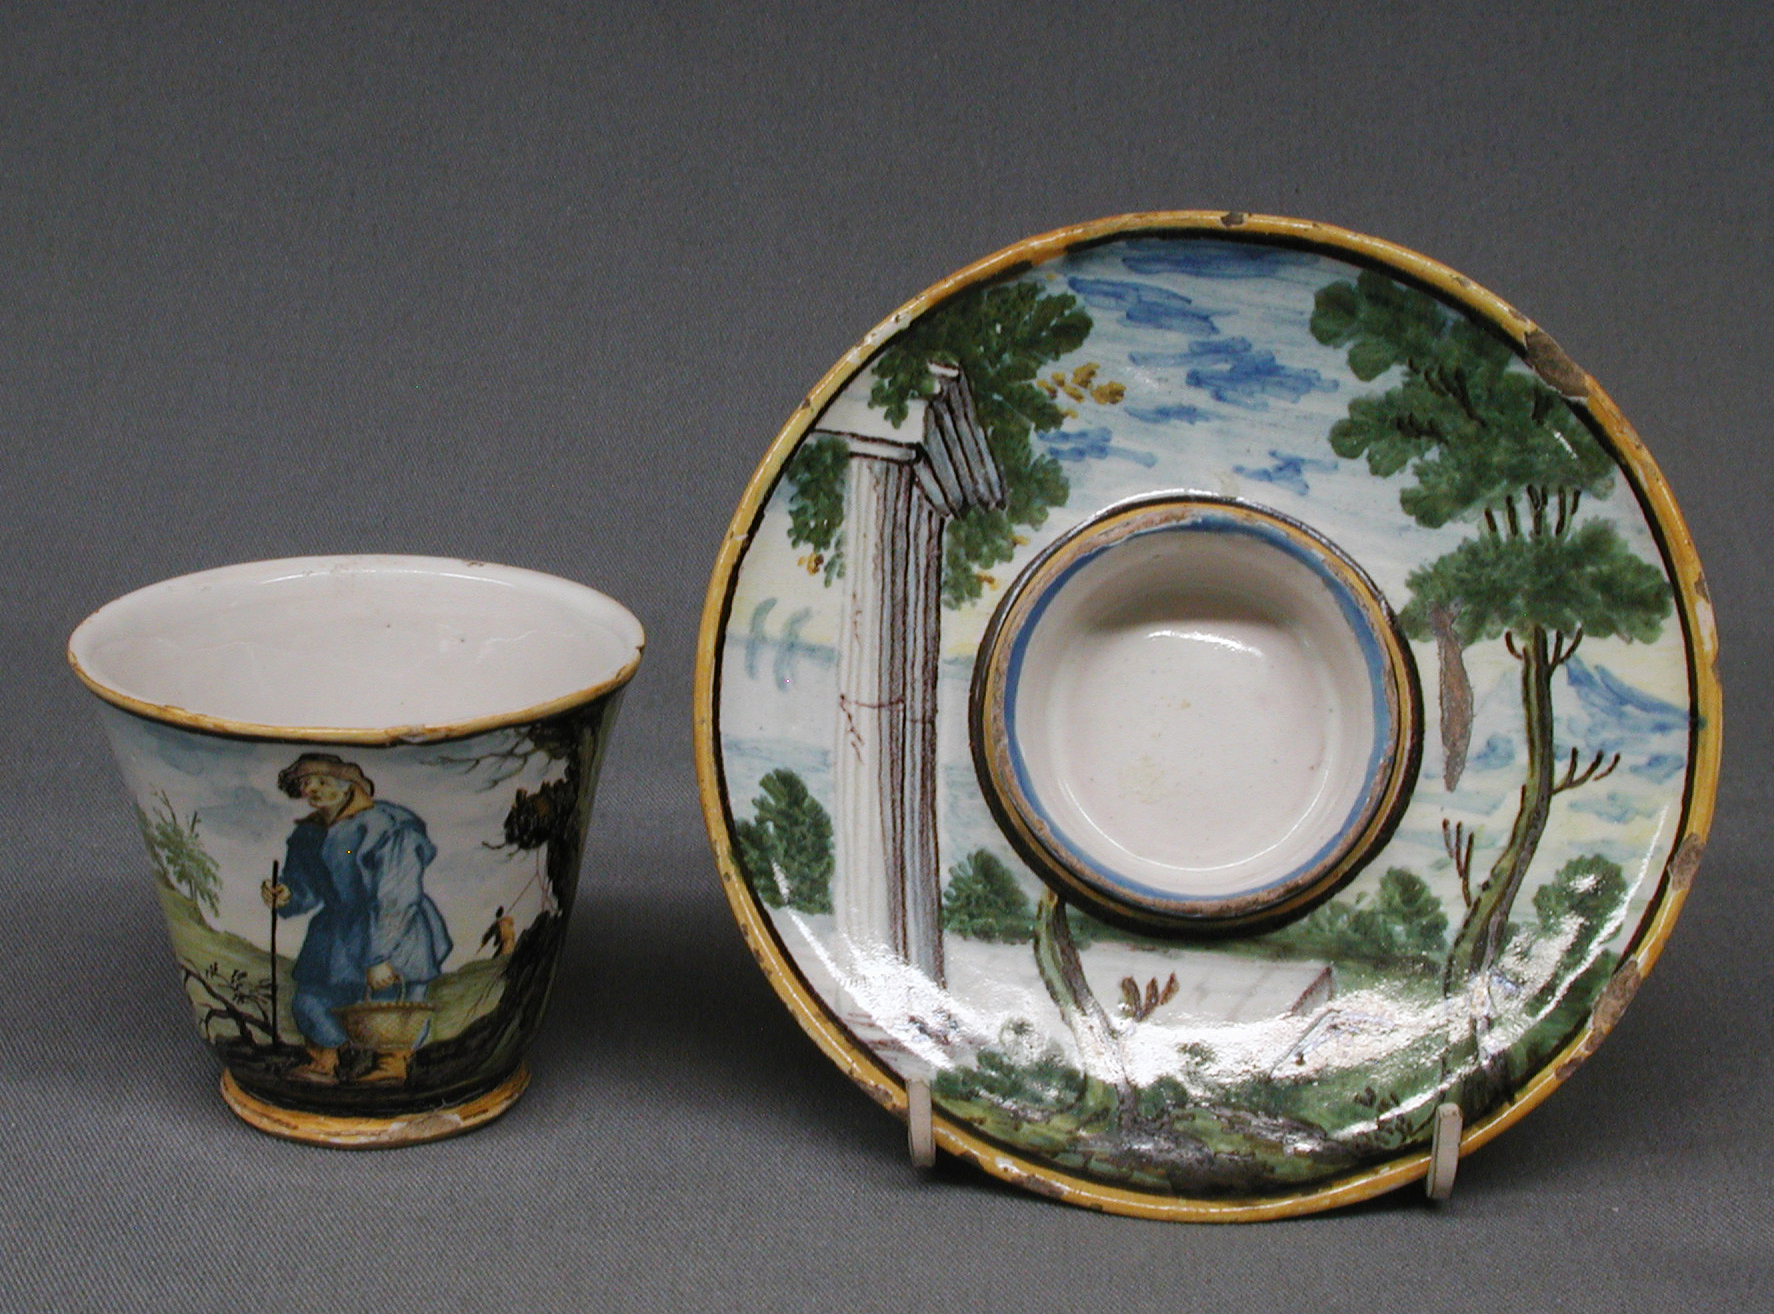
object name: cup and saucer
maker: castelli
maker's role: manufactory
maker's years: 1700-1900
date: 1701-1800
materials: earthenware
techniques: enamel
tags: men